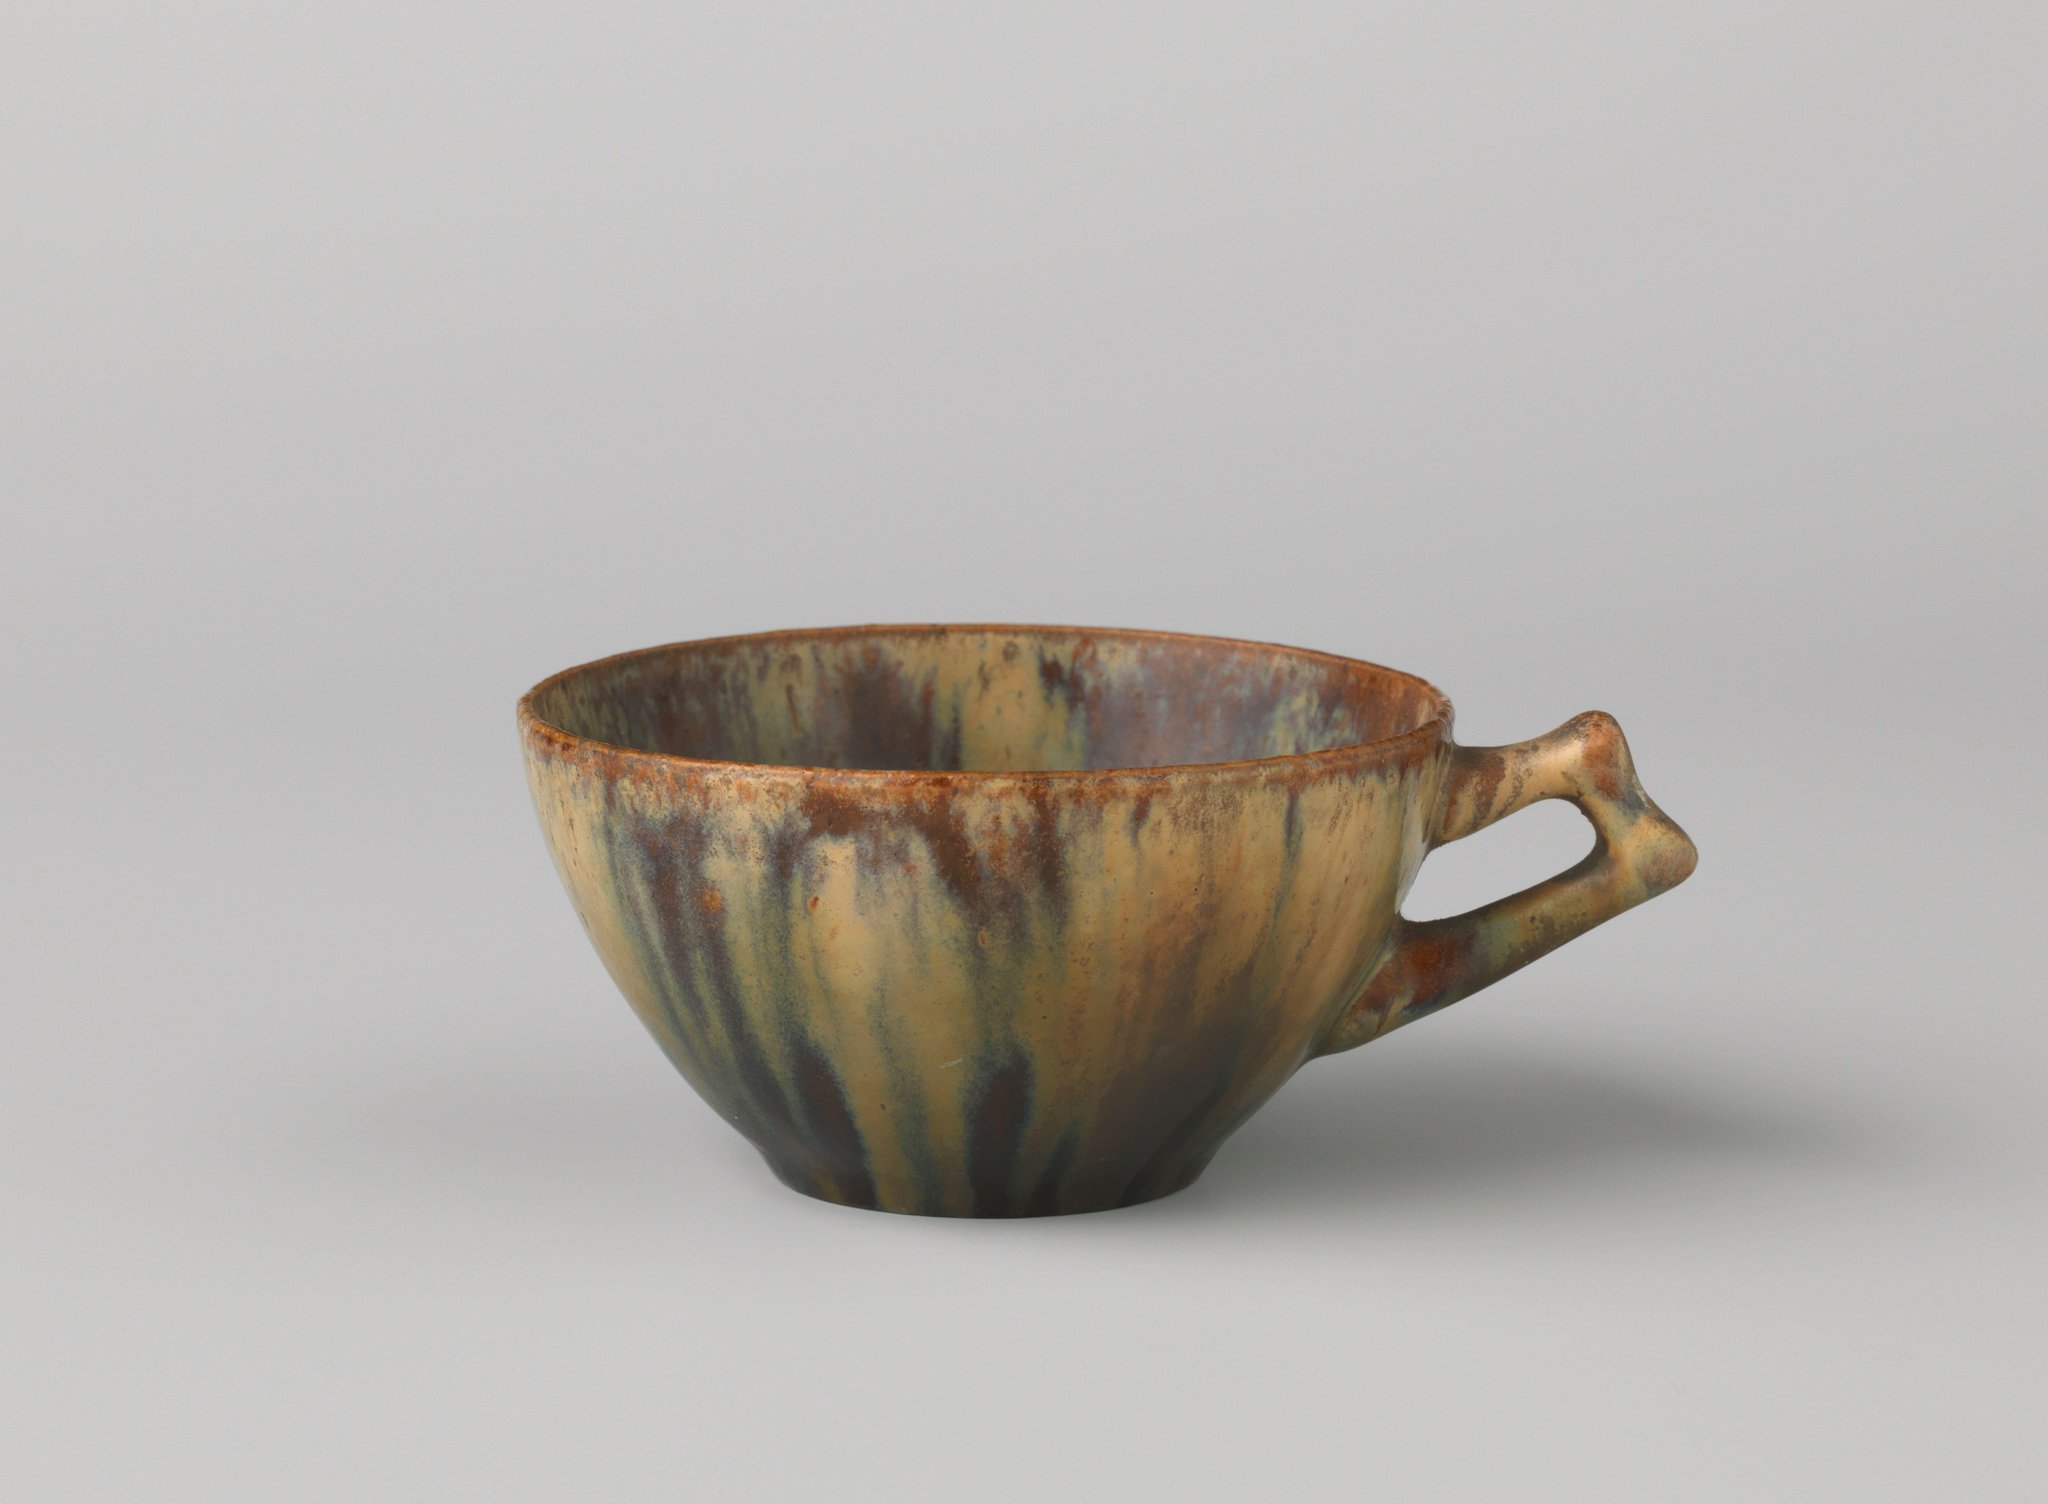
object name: service set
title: Set of Two Cups and Saucers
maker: pierre adrien dalpayrat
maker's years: 1844-1910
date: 1900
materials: earthenware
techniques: vitrification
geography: bourg-la-reine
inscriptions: mark: ‘DALPAYRAT’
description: Kop van aardewerk met een gevlamde roodbruine en gele glazuur.